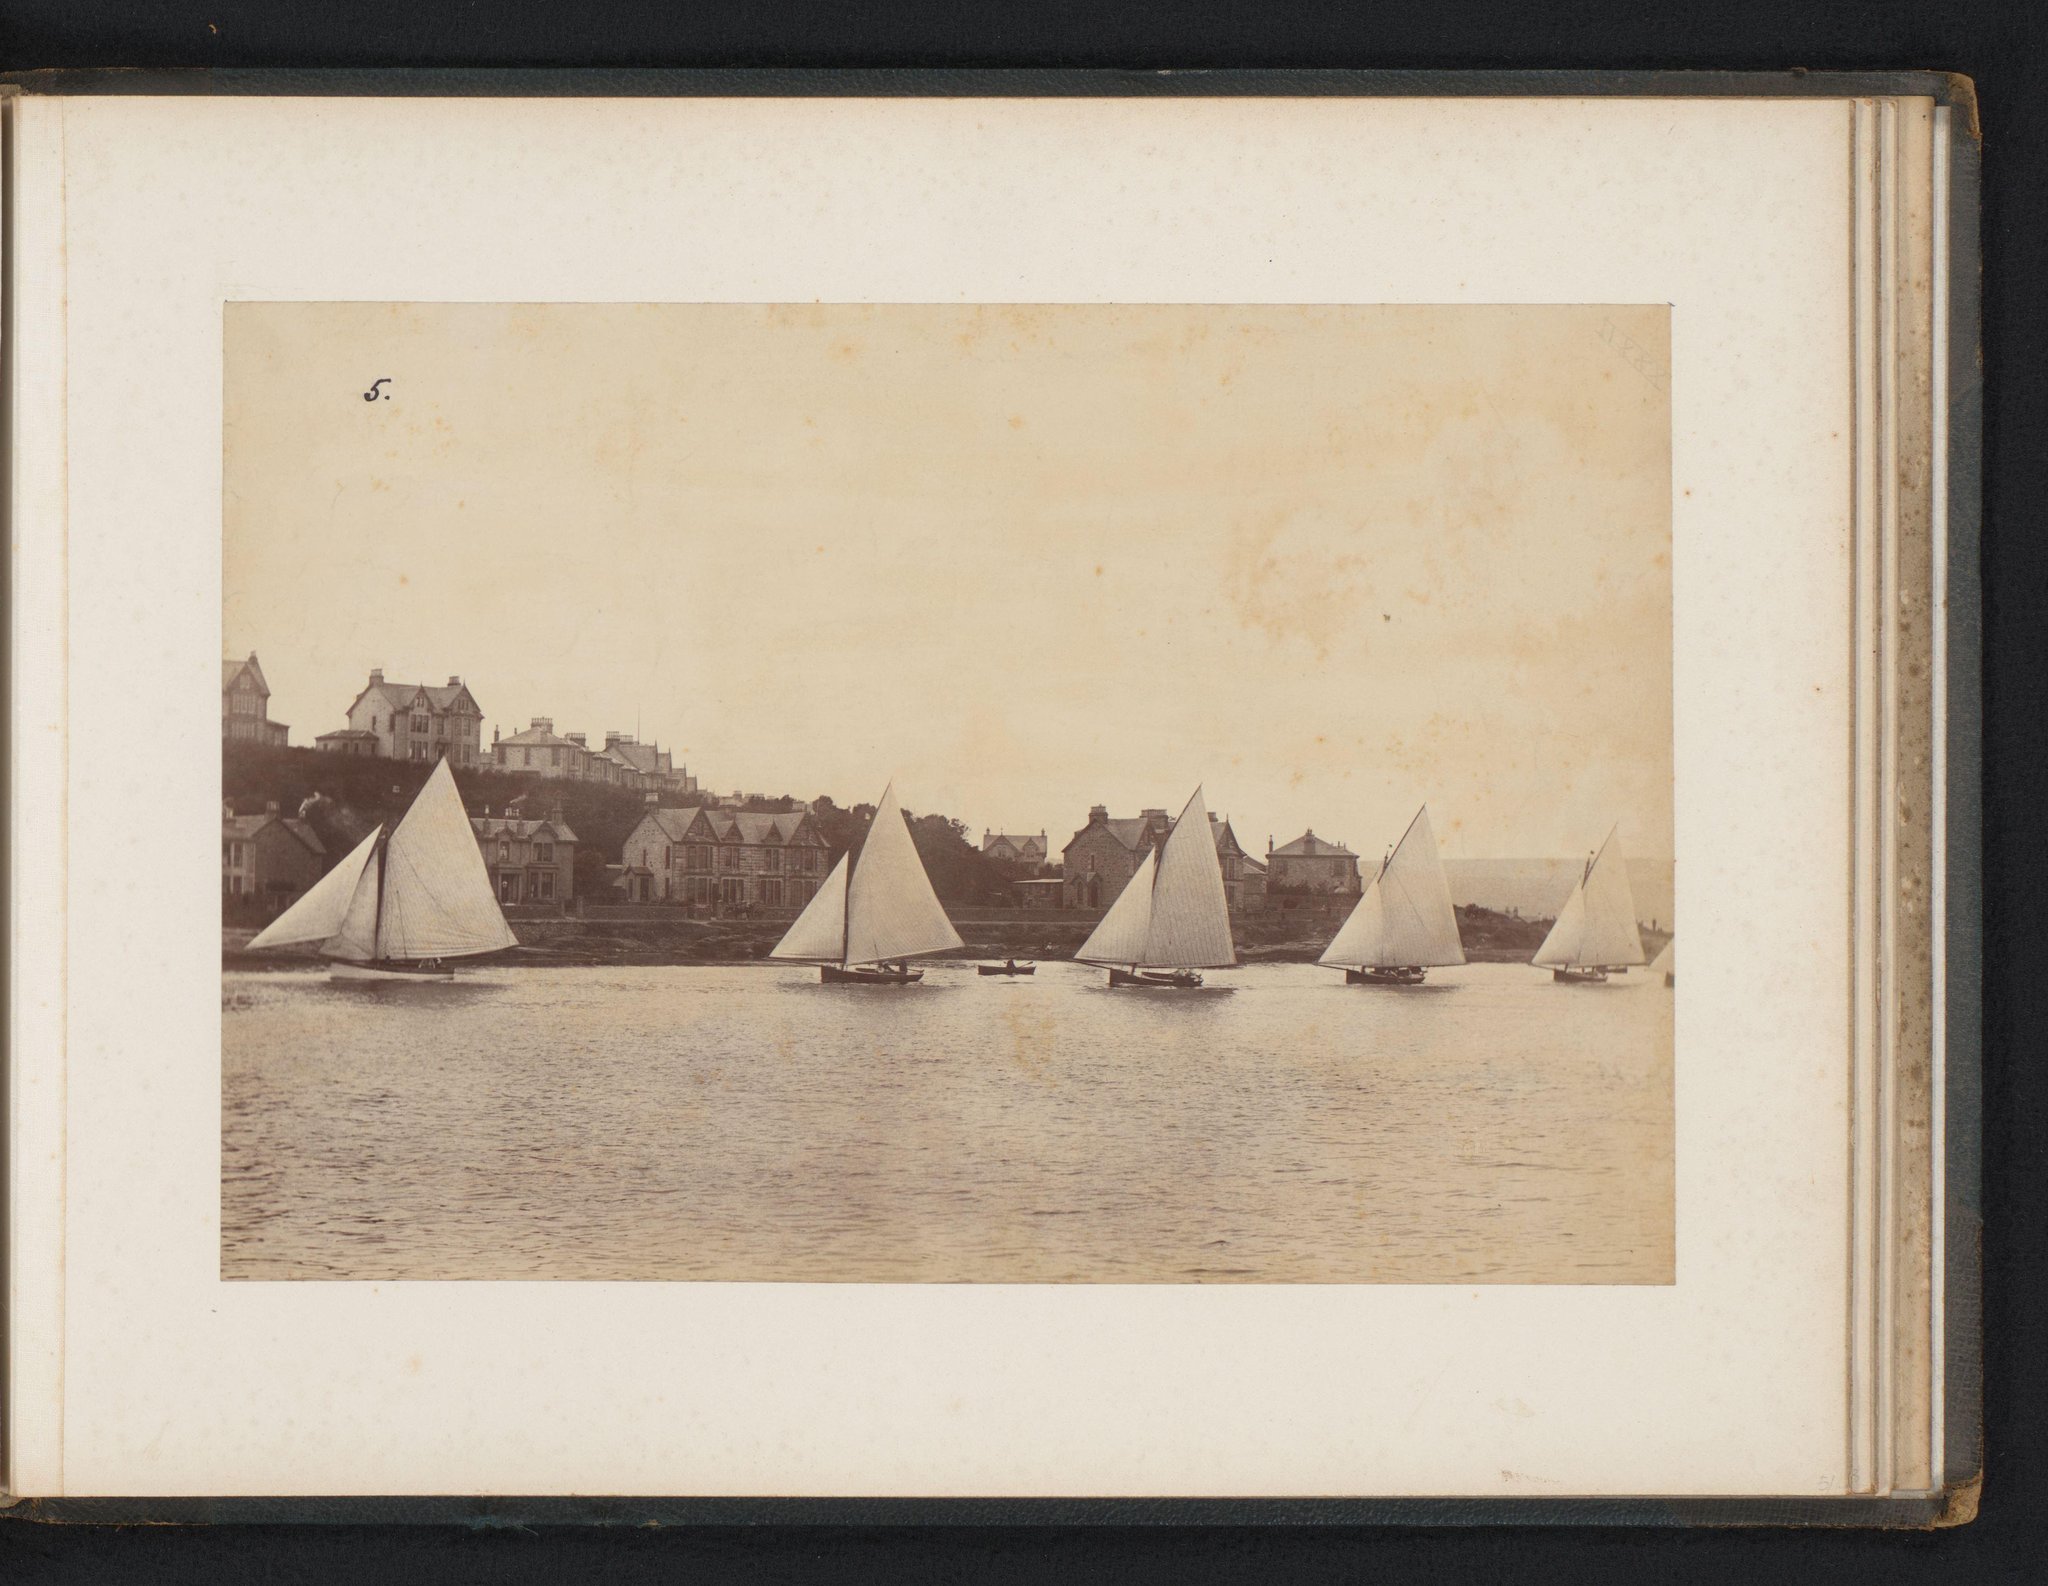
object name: album leaf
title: Verschillende zeilschepen, waaronder de Astore, Dorothy en Caprice, te water met op de achtergrond bebouwing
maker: james adamson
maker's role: fotograaf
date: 1880-1900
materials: photographic support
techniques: albumen print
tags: sailing-ship, sailing-boat, landscapes with waters, waterscapes, seascapes (in the temperate zone), civic architecture; edifices; dwellings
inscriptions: number: ‘5’, check stamp: ‘Adamson, Rothesay.H.B/ Copyright’